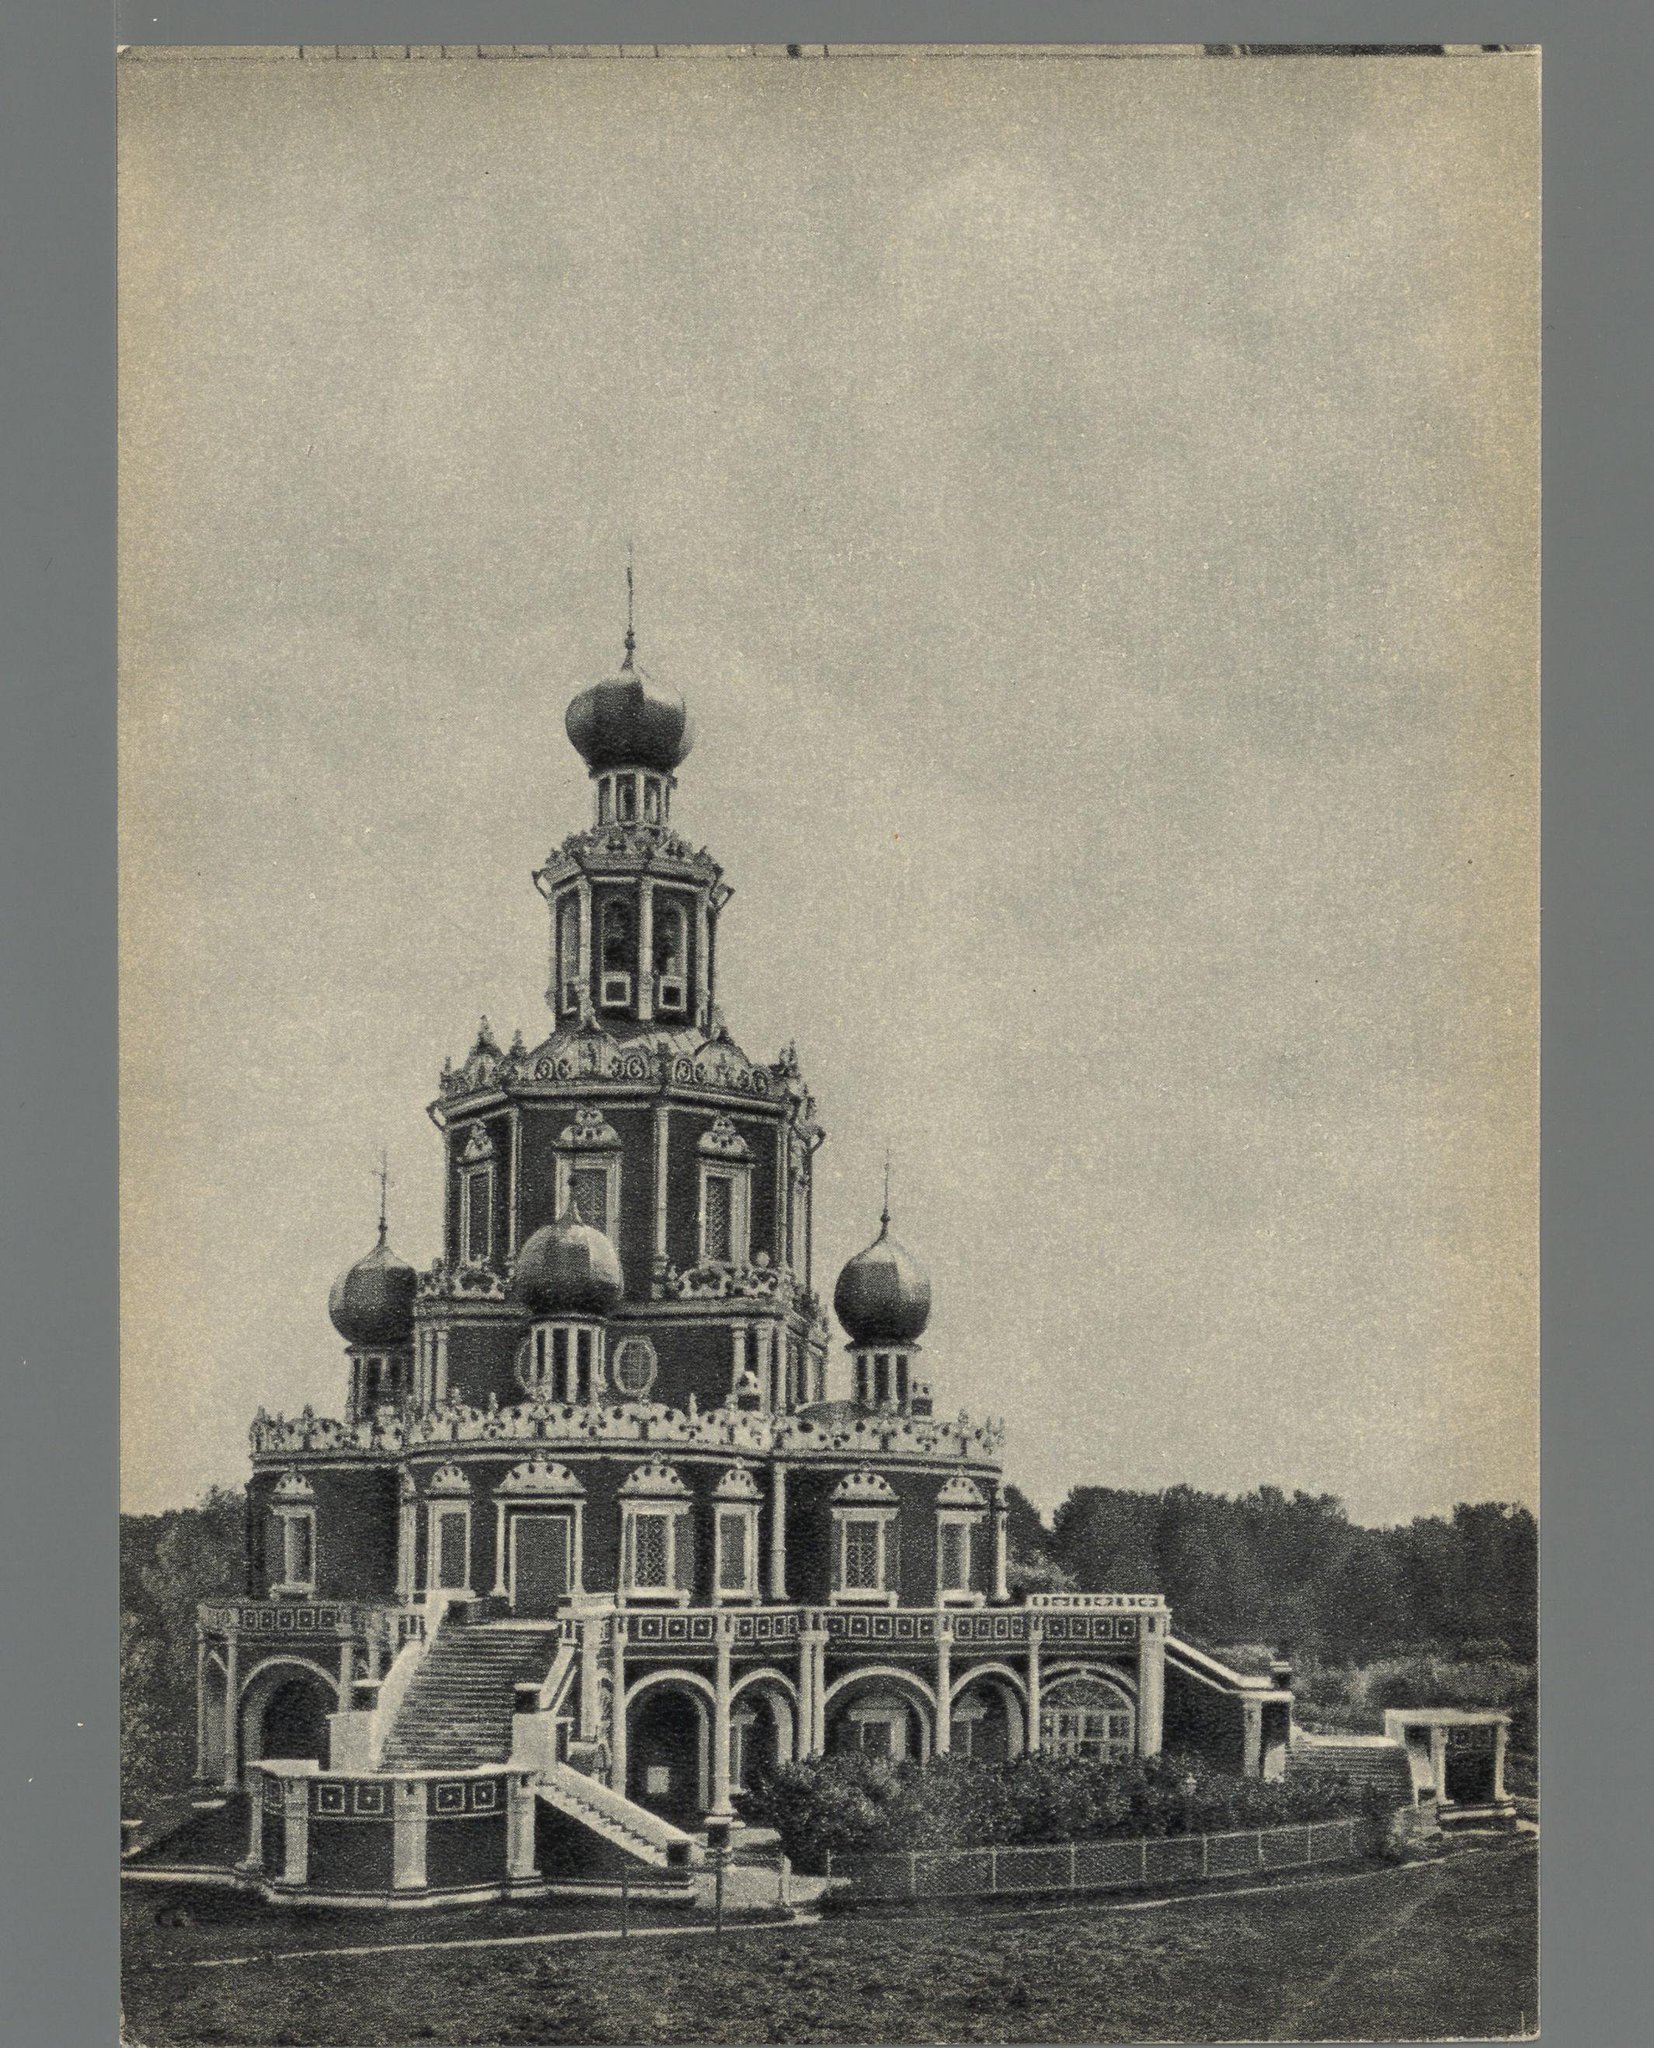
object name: ansichtkaart, prentbriefkaart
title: Gezicht op de Voorbedekerk te Fili, Moskou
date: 1957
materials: cardboard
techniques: rotogravure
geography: moscow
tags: church (exterior)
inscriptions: date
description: De titel op object staat in het Russisch.